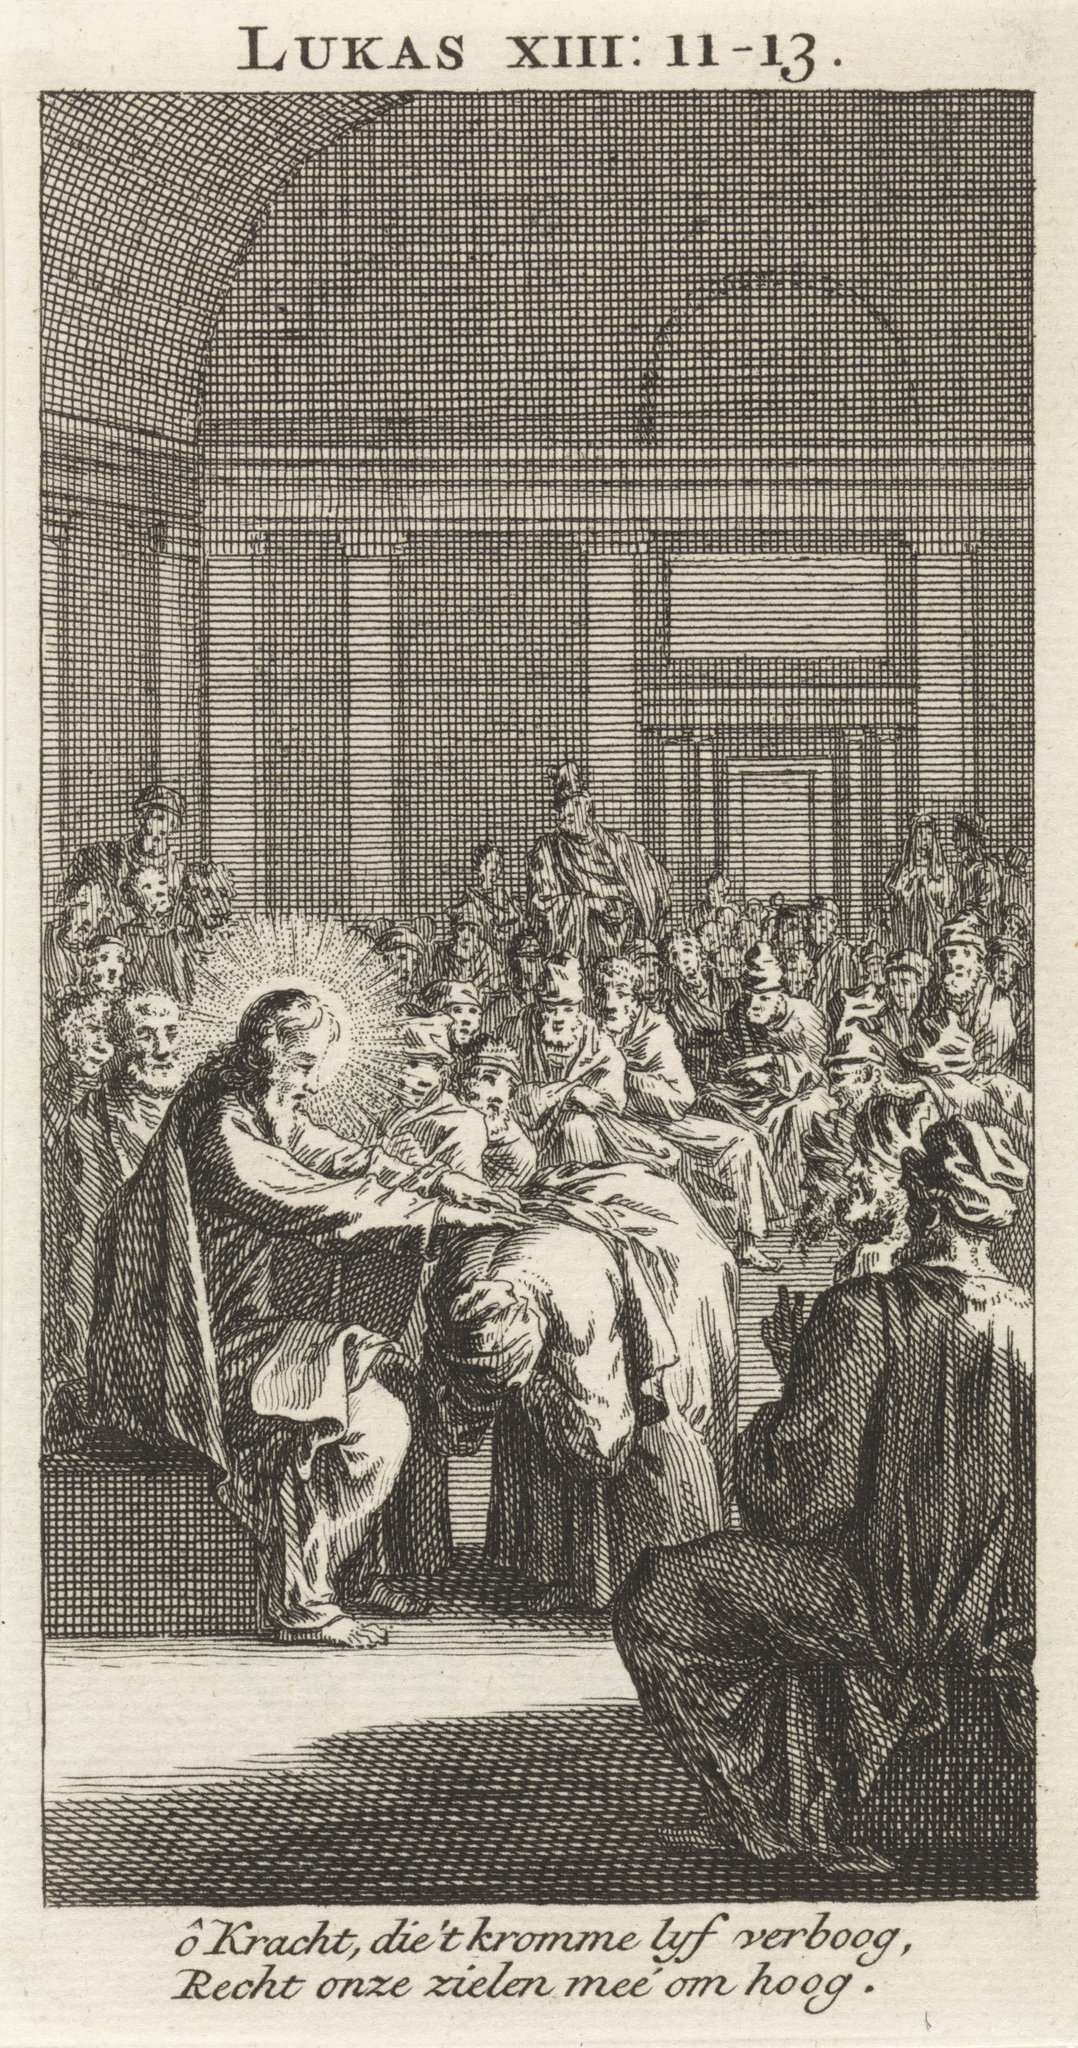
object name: print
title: Christus legt zijn hand op de krom getrokken vrouw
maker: Anonymous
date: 1712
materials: paper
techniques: etching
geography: amsterdam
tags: healing of a woman 'bent over' (luke 13:10-17)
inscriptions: collector's mark: Lugt 2228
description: Kopie van illustratie voor: Luyken, Jan. Bybel printen. Amsterdam: Pieter Arentsz. II (wed.) en Cornelis van der Sys, 1712, p. 27.